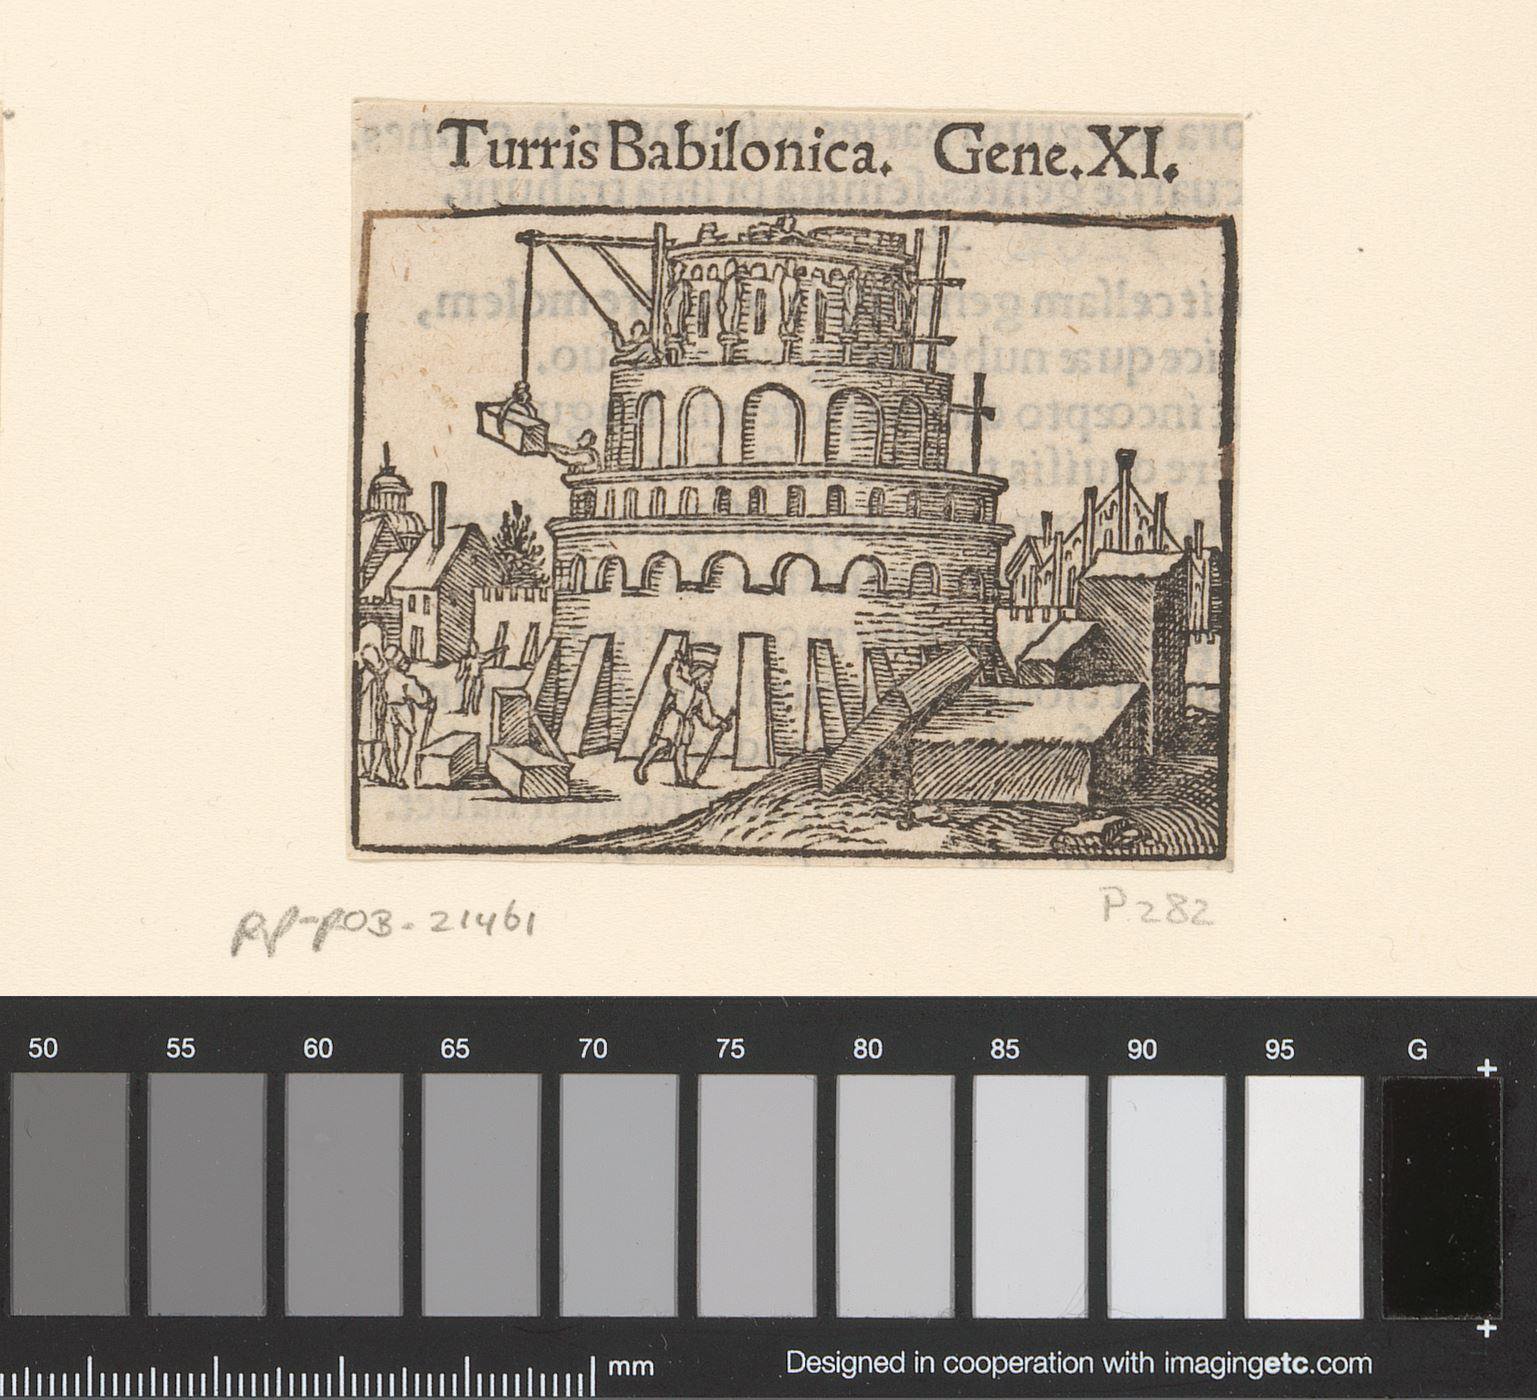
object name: book illustration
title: Bouw van de toren van Babel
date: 1530-1533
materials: paper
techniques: letterpress printing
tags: the tower of babel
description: Prent afkomstig uit: Biblicae historiae. Frankfurt am Main: Egenloph, 1539.